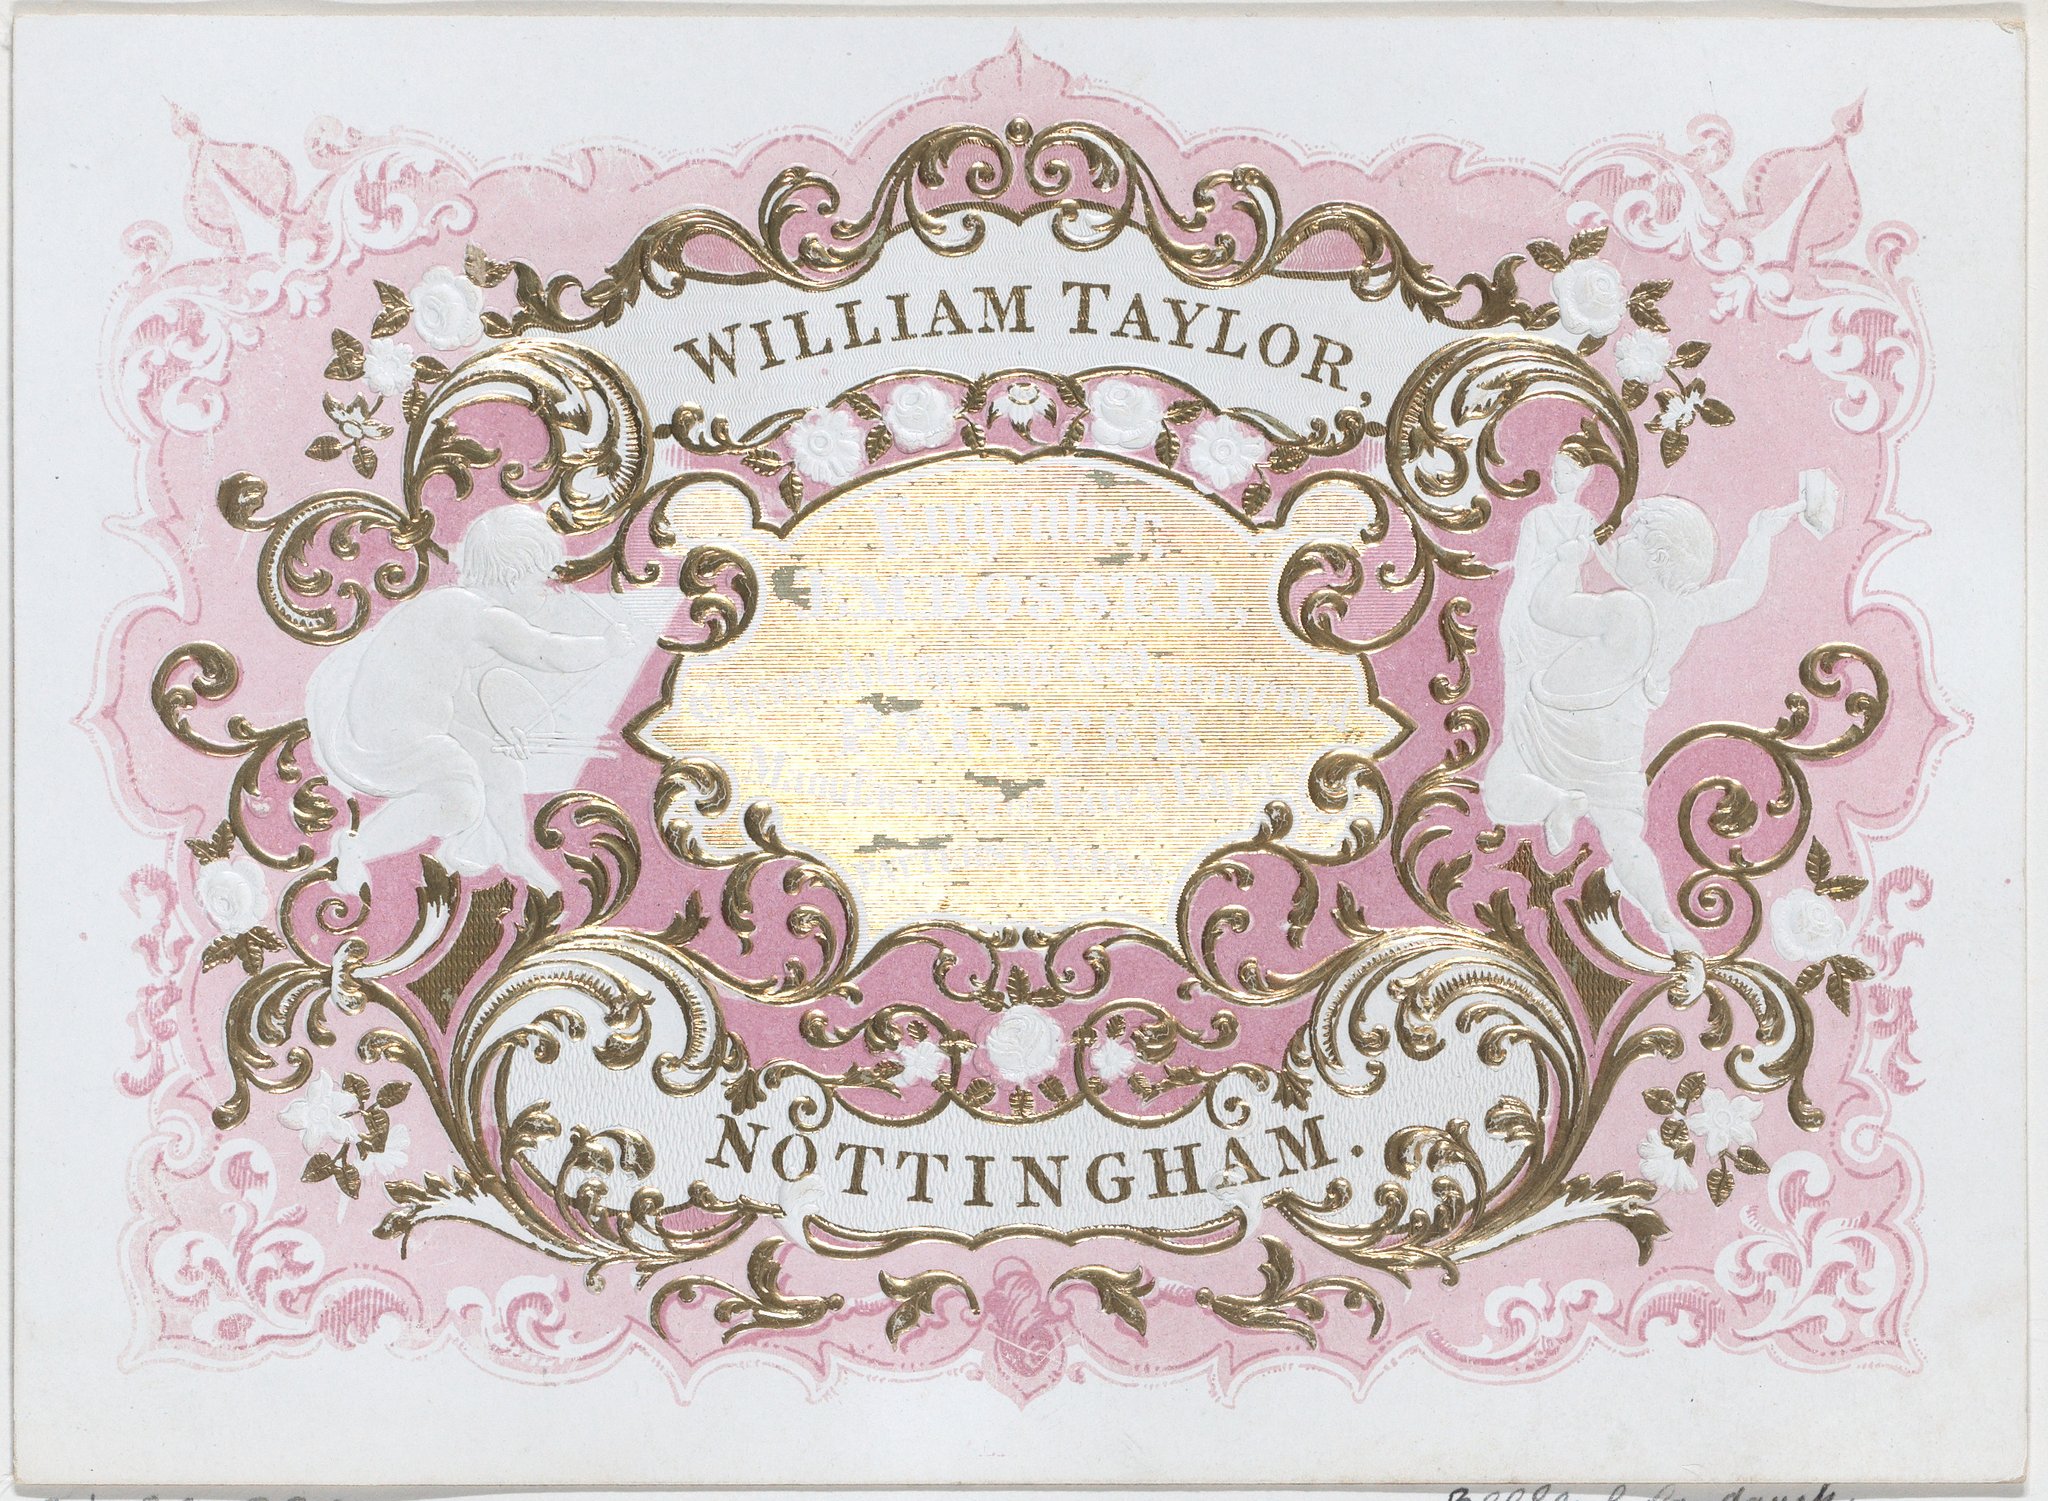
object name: print, trade card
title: Trade Card for William Taylor, Engraver, Embosser & Printer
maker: anonymous, british, 19th century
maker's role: artist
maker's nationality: british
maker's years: 1800-1900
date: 1801-1900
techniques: lithograph